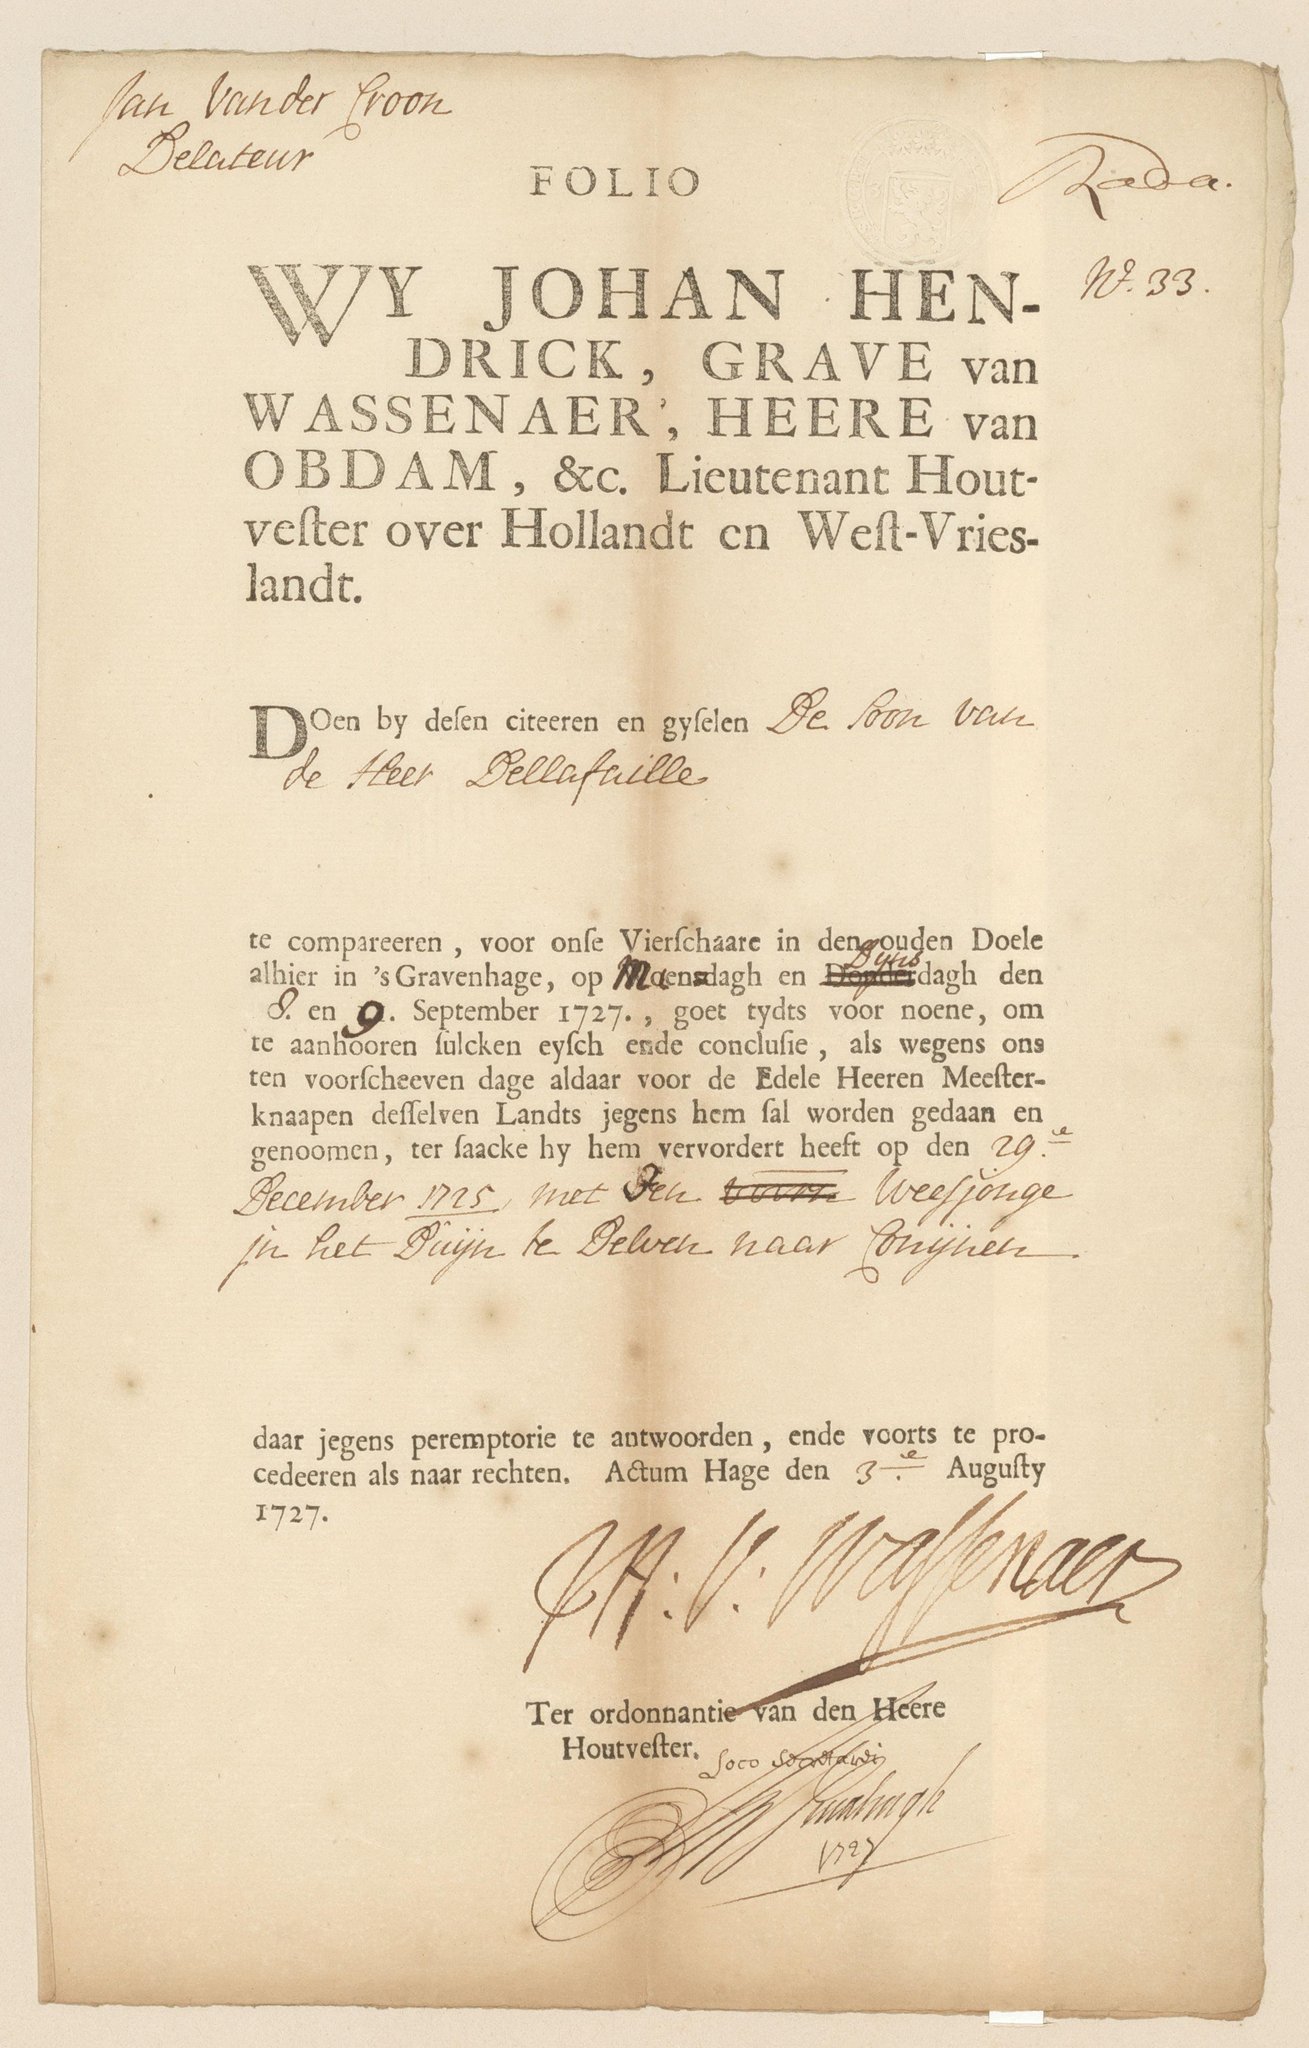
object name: document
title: Dagvaarding voor het delven van konijnen in de Houtvesterij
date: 1727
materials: paper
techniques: letterpress printing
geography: the hague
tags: holland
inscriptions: check stamp: ‘cleyn segel 1727’, stamp, inscription, collector's mark: Lugt 1641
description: Dagvaarding voor de zoon van de Heer Dellafaille. Hij is betrapt op het delven (uitgraven) van konijnen in de duinen van de Houtvesterij in Holland en West-Friesland. De zoon was samen met jongen uit het weeshuis. De dagvaarding is uitgegeven door Johan Hendrik rijksgraaf en baanderheer van Wassenaer heer van Obdam. Object bestaat uit twee pagina's. Onderwerpsrubrieken binnen de Atlas Zeden en Gewoonten: Rechtswezen, Rechtspraak en Rechtswezen.